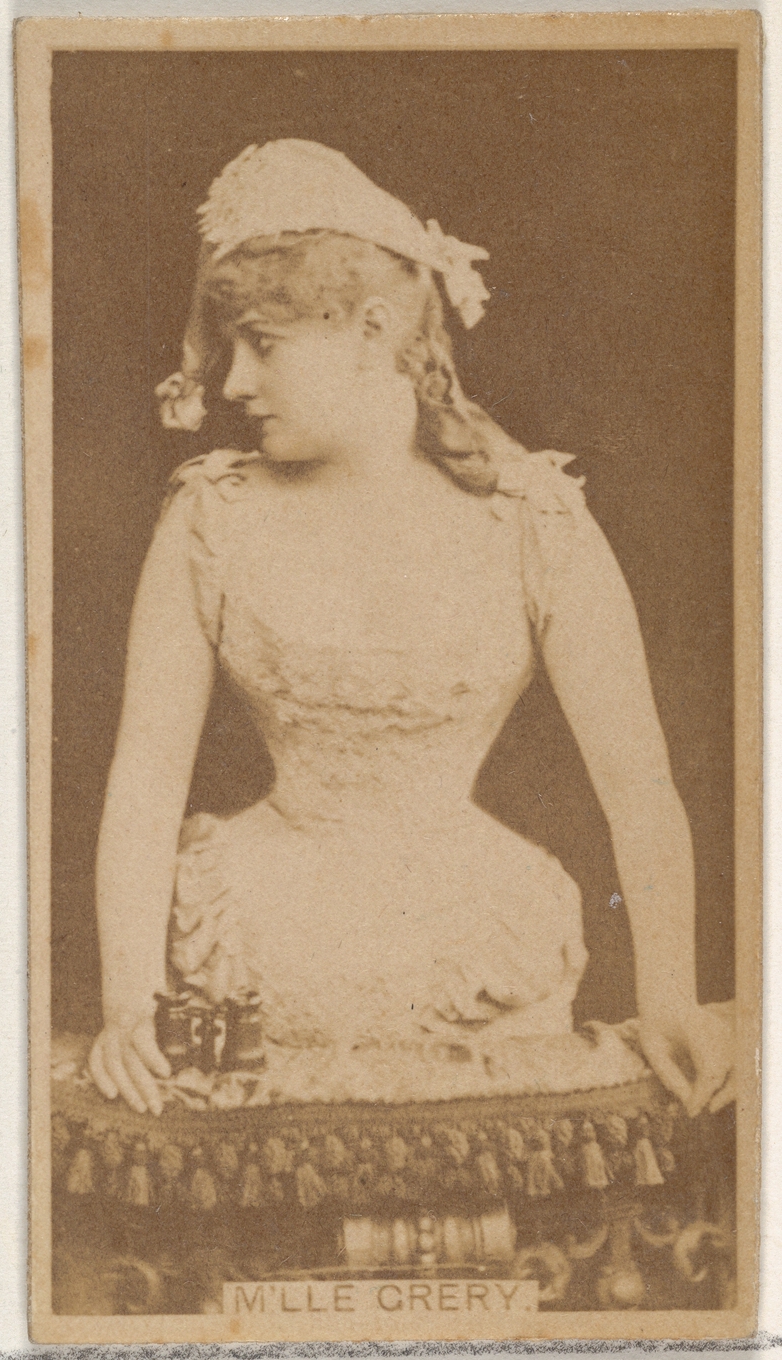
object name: photograph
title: M'lle Grery, from the Actors and Actresses series (N45, Type 8) for Virginia Brights Cigarettes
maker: allen & ginter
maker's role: publisher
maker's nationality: american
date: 1888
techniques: albumen silver print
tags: portraits,women,actresses